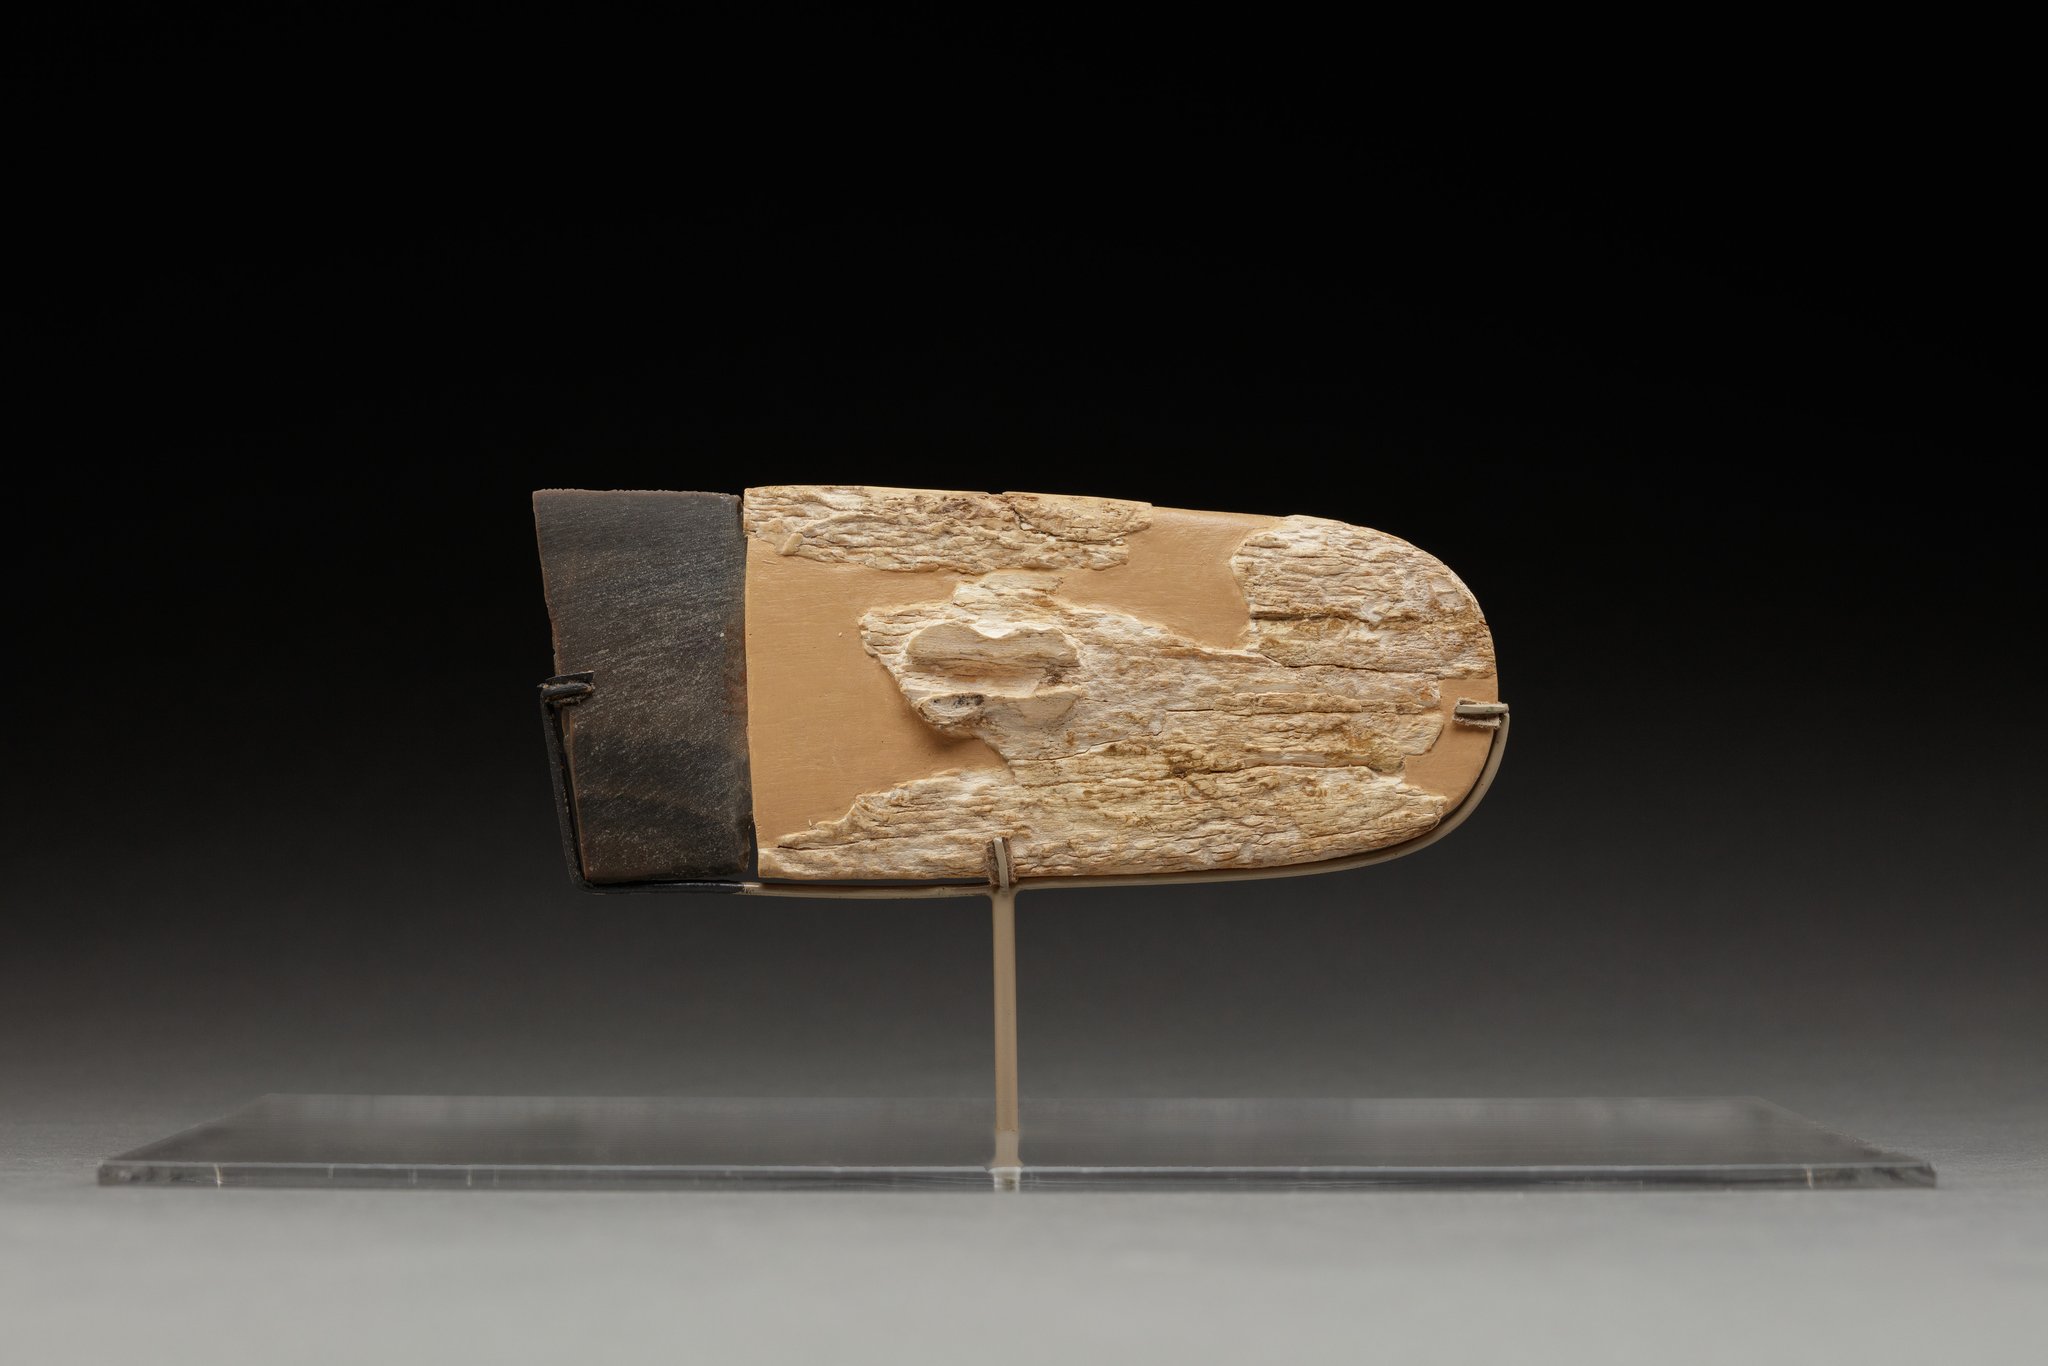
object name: knife, ivory handle, ripple flaked, bifacial knife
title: Carved handle of a ceremonial knife with part of the ripple-flaked knife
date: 3200 BCE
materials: stone, ivory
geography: egypt